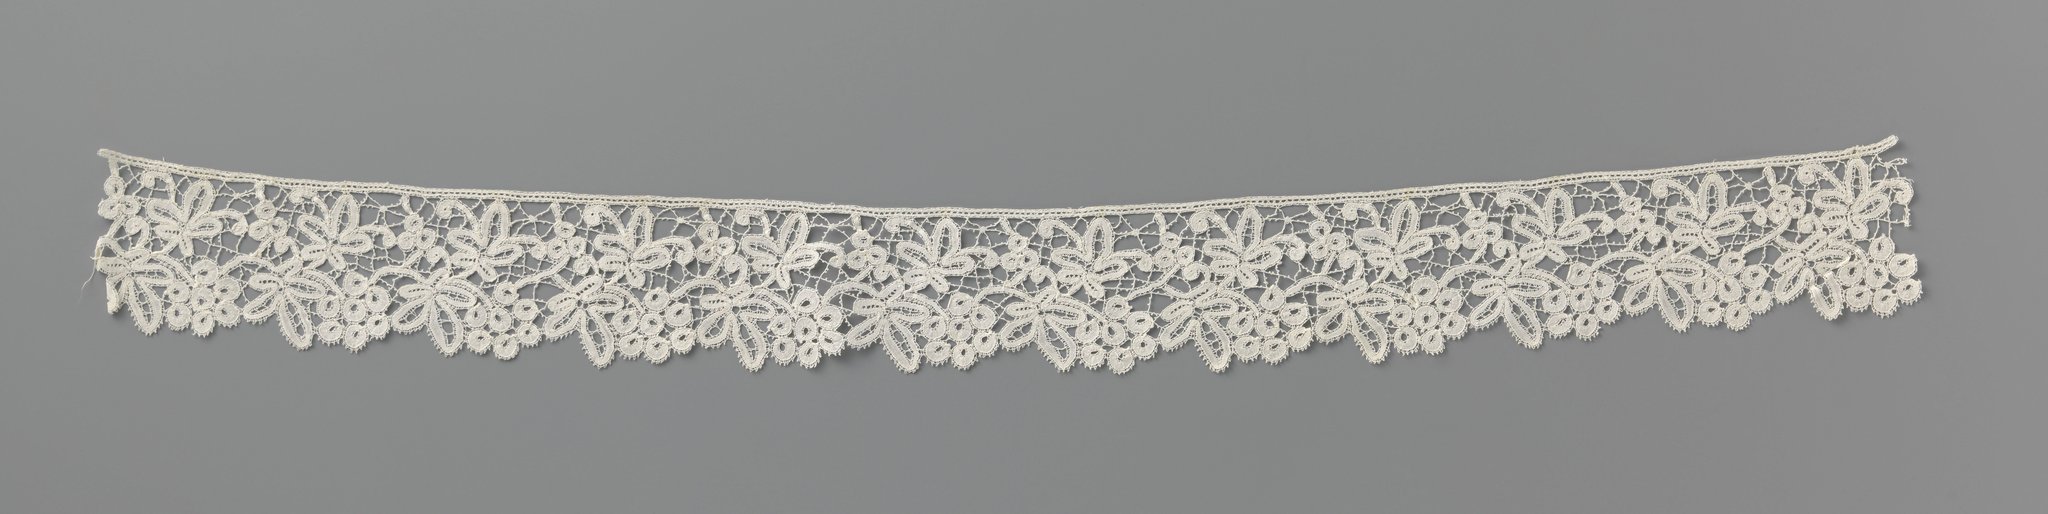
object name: strip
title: Strook kloskant met de druiventrossen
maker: Anonymous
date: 1875-1899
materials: linen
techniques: lace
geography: netherlands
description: Strook naturelkleurige kloskant: duchesse-kant. Op een open vlechtengrond staat een lopend patroon van een korte tak met twee wingerdbladeren en een druiventros. Om beurten vormen een blad en de tros de ongelijke schulpen.